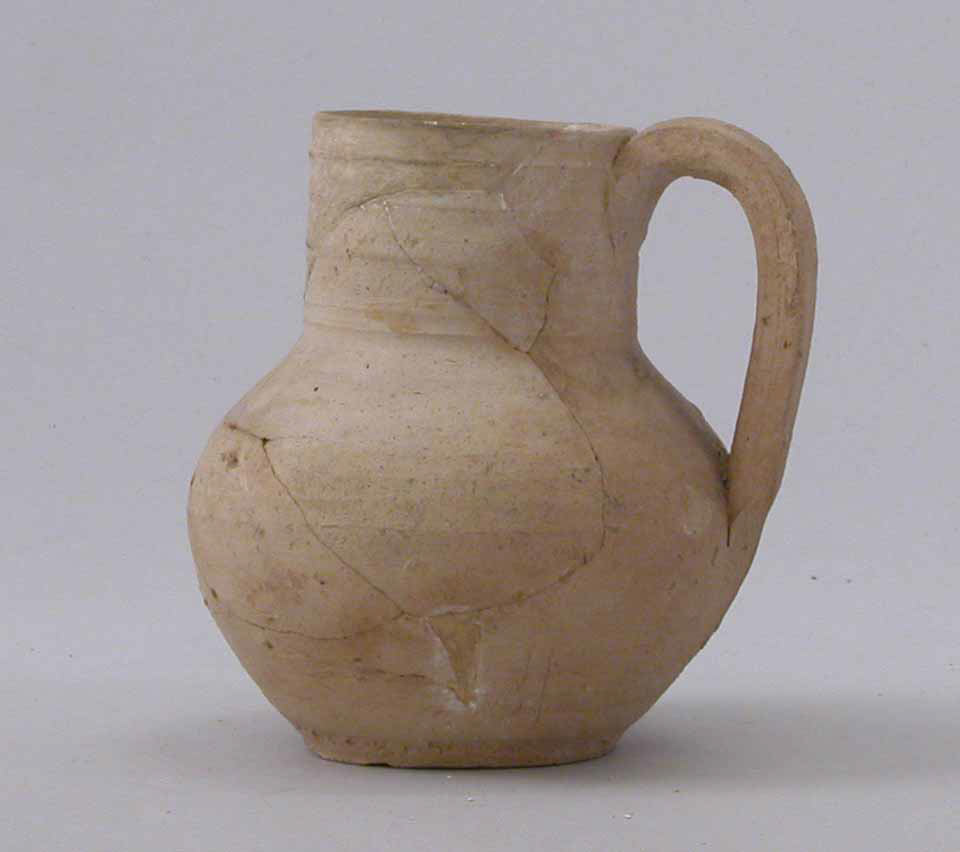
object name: ewer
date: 801-933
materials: earthenware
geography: iran